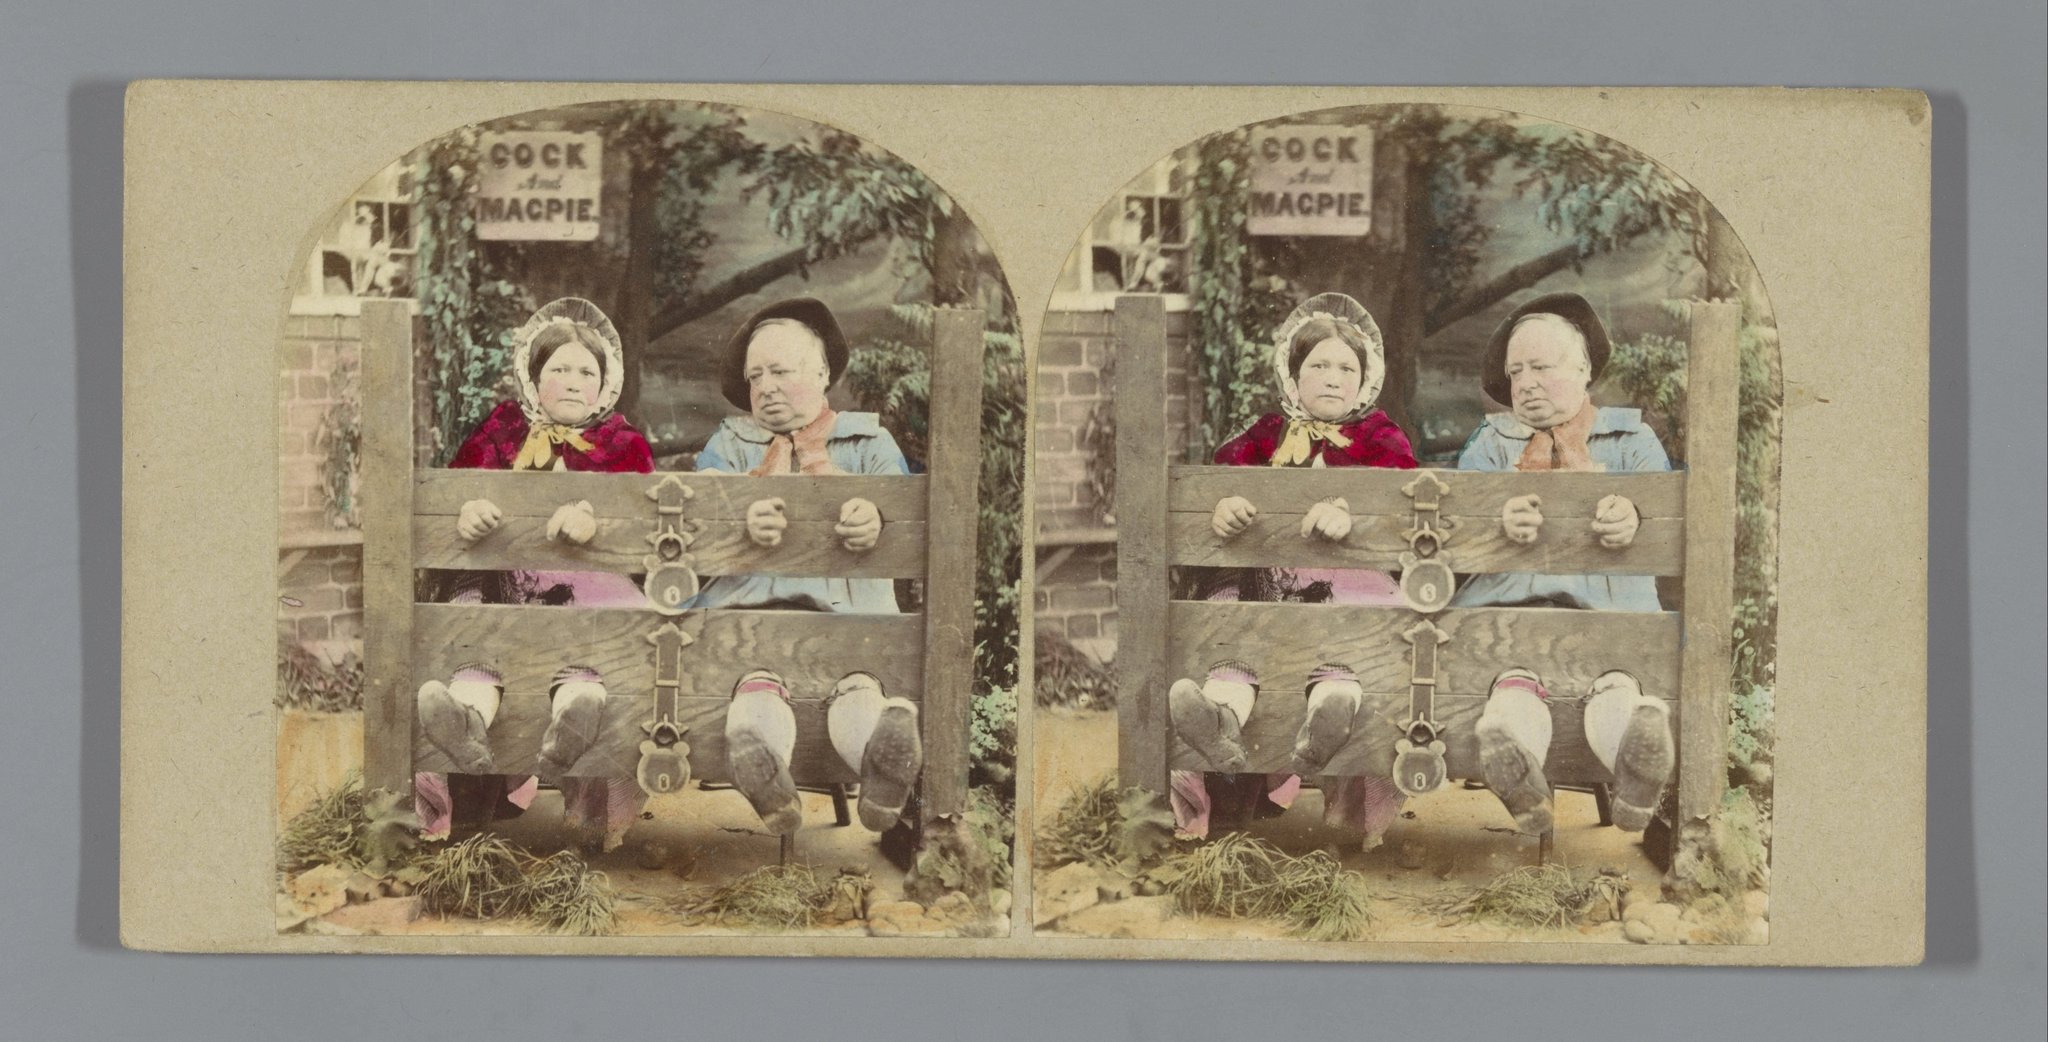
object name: stereograph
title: Twee personen aan een schandblok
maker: Anonymous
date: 1852-1863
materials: cardboard, paper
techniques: albumen print, hand coloring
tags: in the pillory, in the stocks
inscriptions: inscription: ‘Registered.’, inscription: ‘6,-’